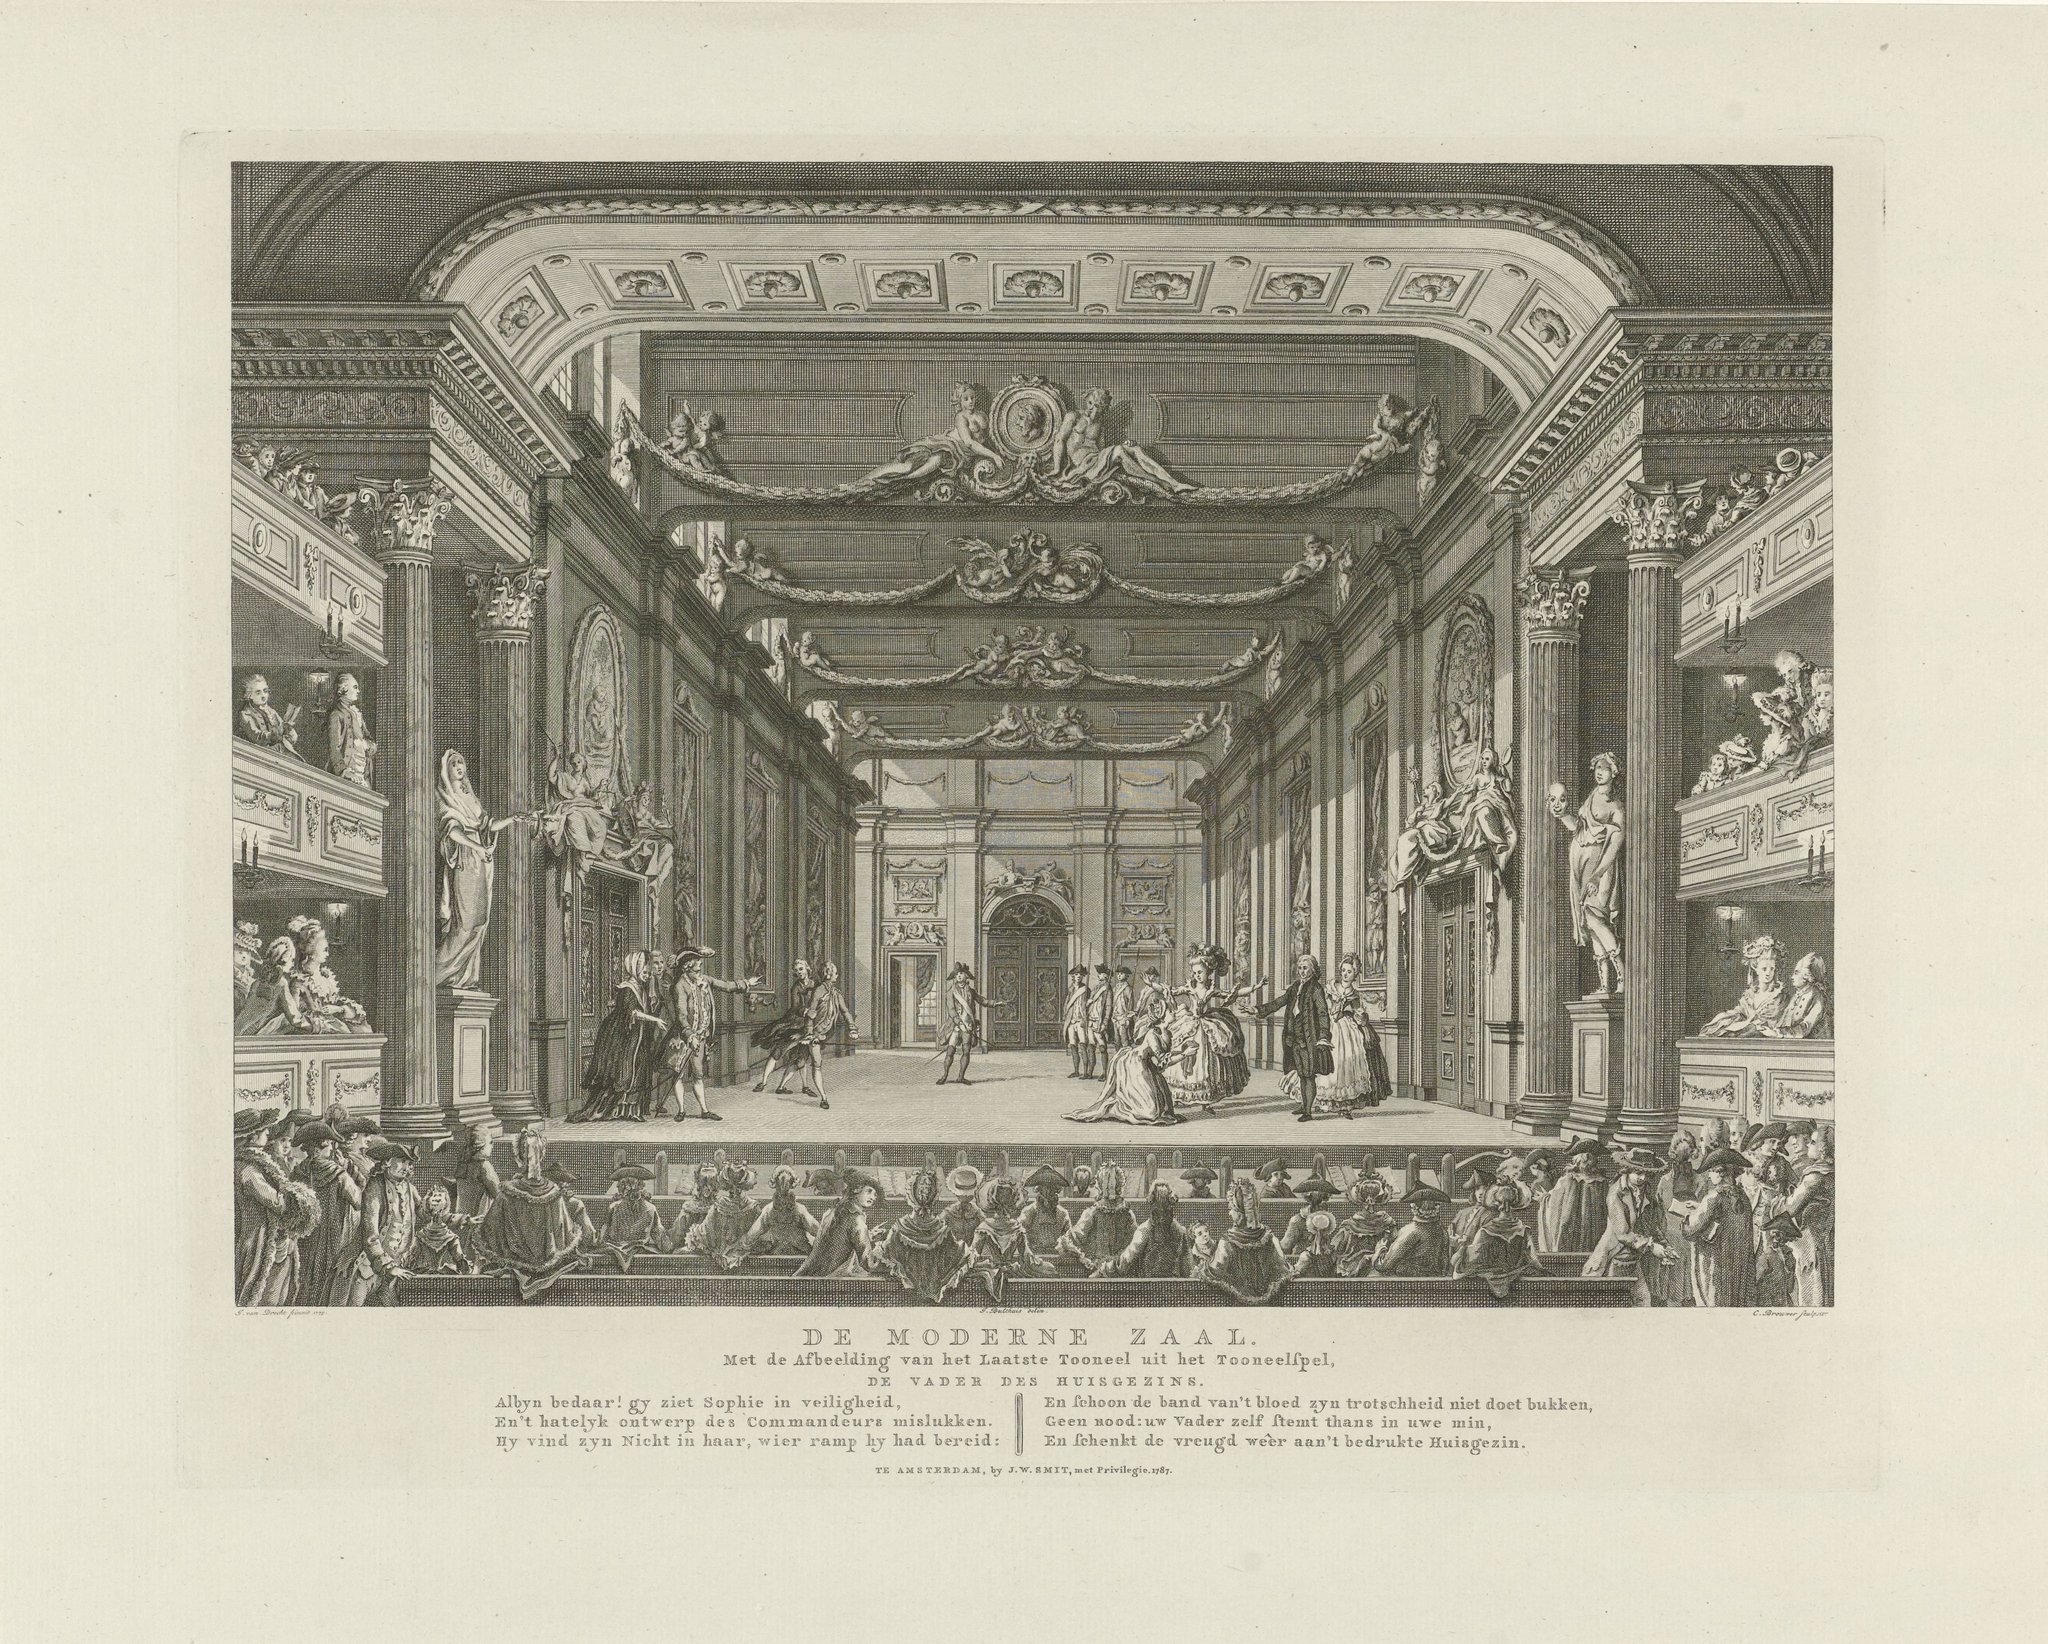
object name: print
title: De Moderne Zaal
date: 1787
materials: paper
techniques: engraving, etching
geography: northern netherlands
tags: theatre, theatrical performance, stage design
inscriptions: collector's mark: Lugt 2228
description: Toneelvoorstelling in de nieuwe Amsterdamse Schouwburg met het coulissendecor De Moderne Zaal, met scène uit De Vader des Huisgezins. Het decor gedrukt van een aparte plaat binnen een passe-partout met de zaal, zijloges, pilaren met standbeelden en de façade van het toneel. In het onderschrift een zesregelig vers. Onderdeel van de serie van veertien toneeldecors van de nieuwe Amsterdamse Schouwburg, 1787-1794.